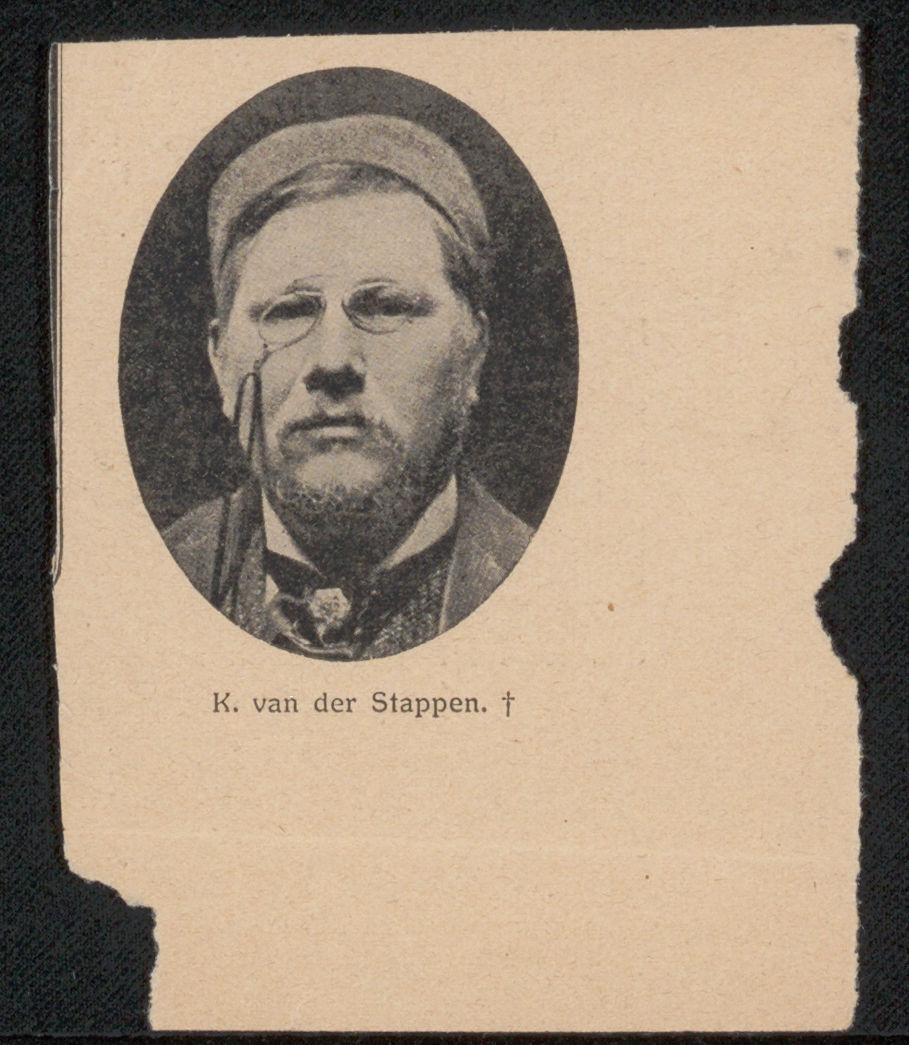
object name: print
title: Portret van Charles van der Stappen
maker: Anonymous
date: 1910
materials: paper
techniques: photochemical processes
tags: brussels, sculptor, charles van der stappen, historical persons (portraits and scenes from the life)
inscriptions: collector's mark: ‘RPK’